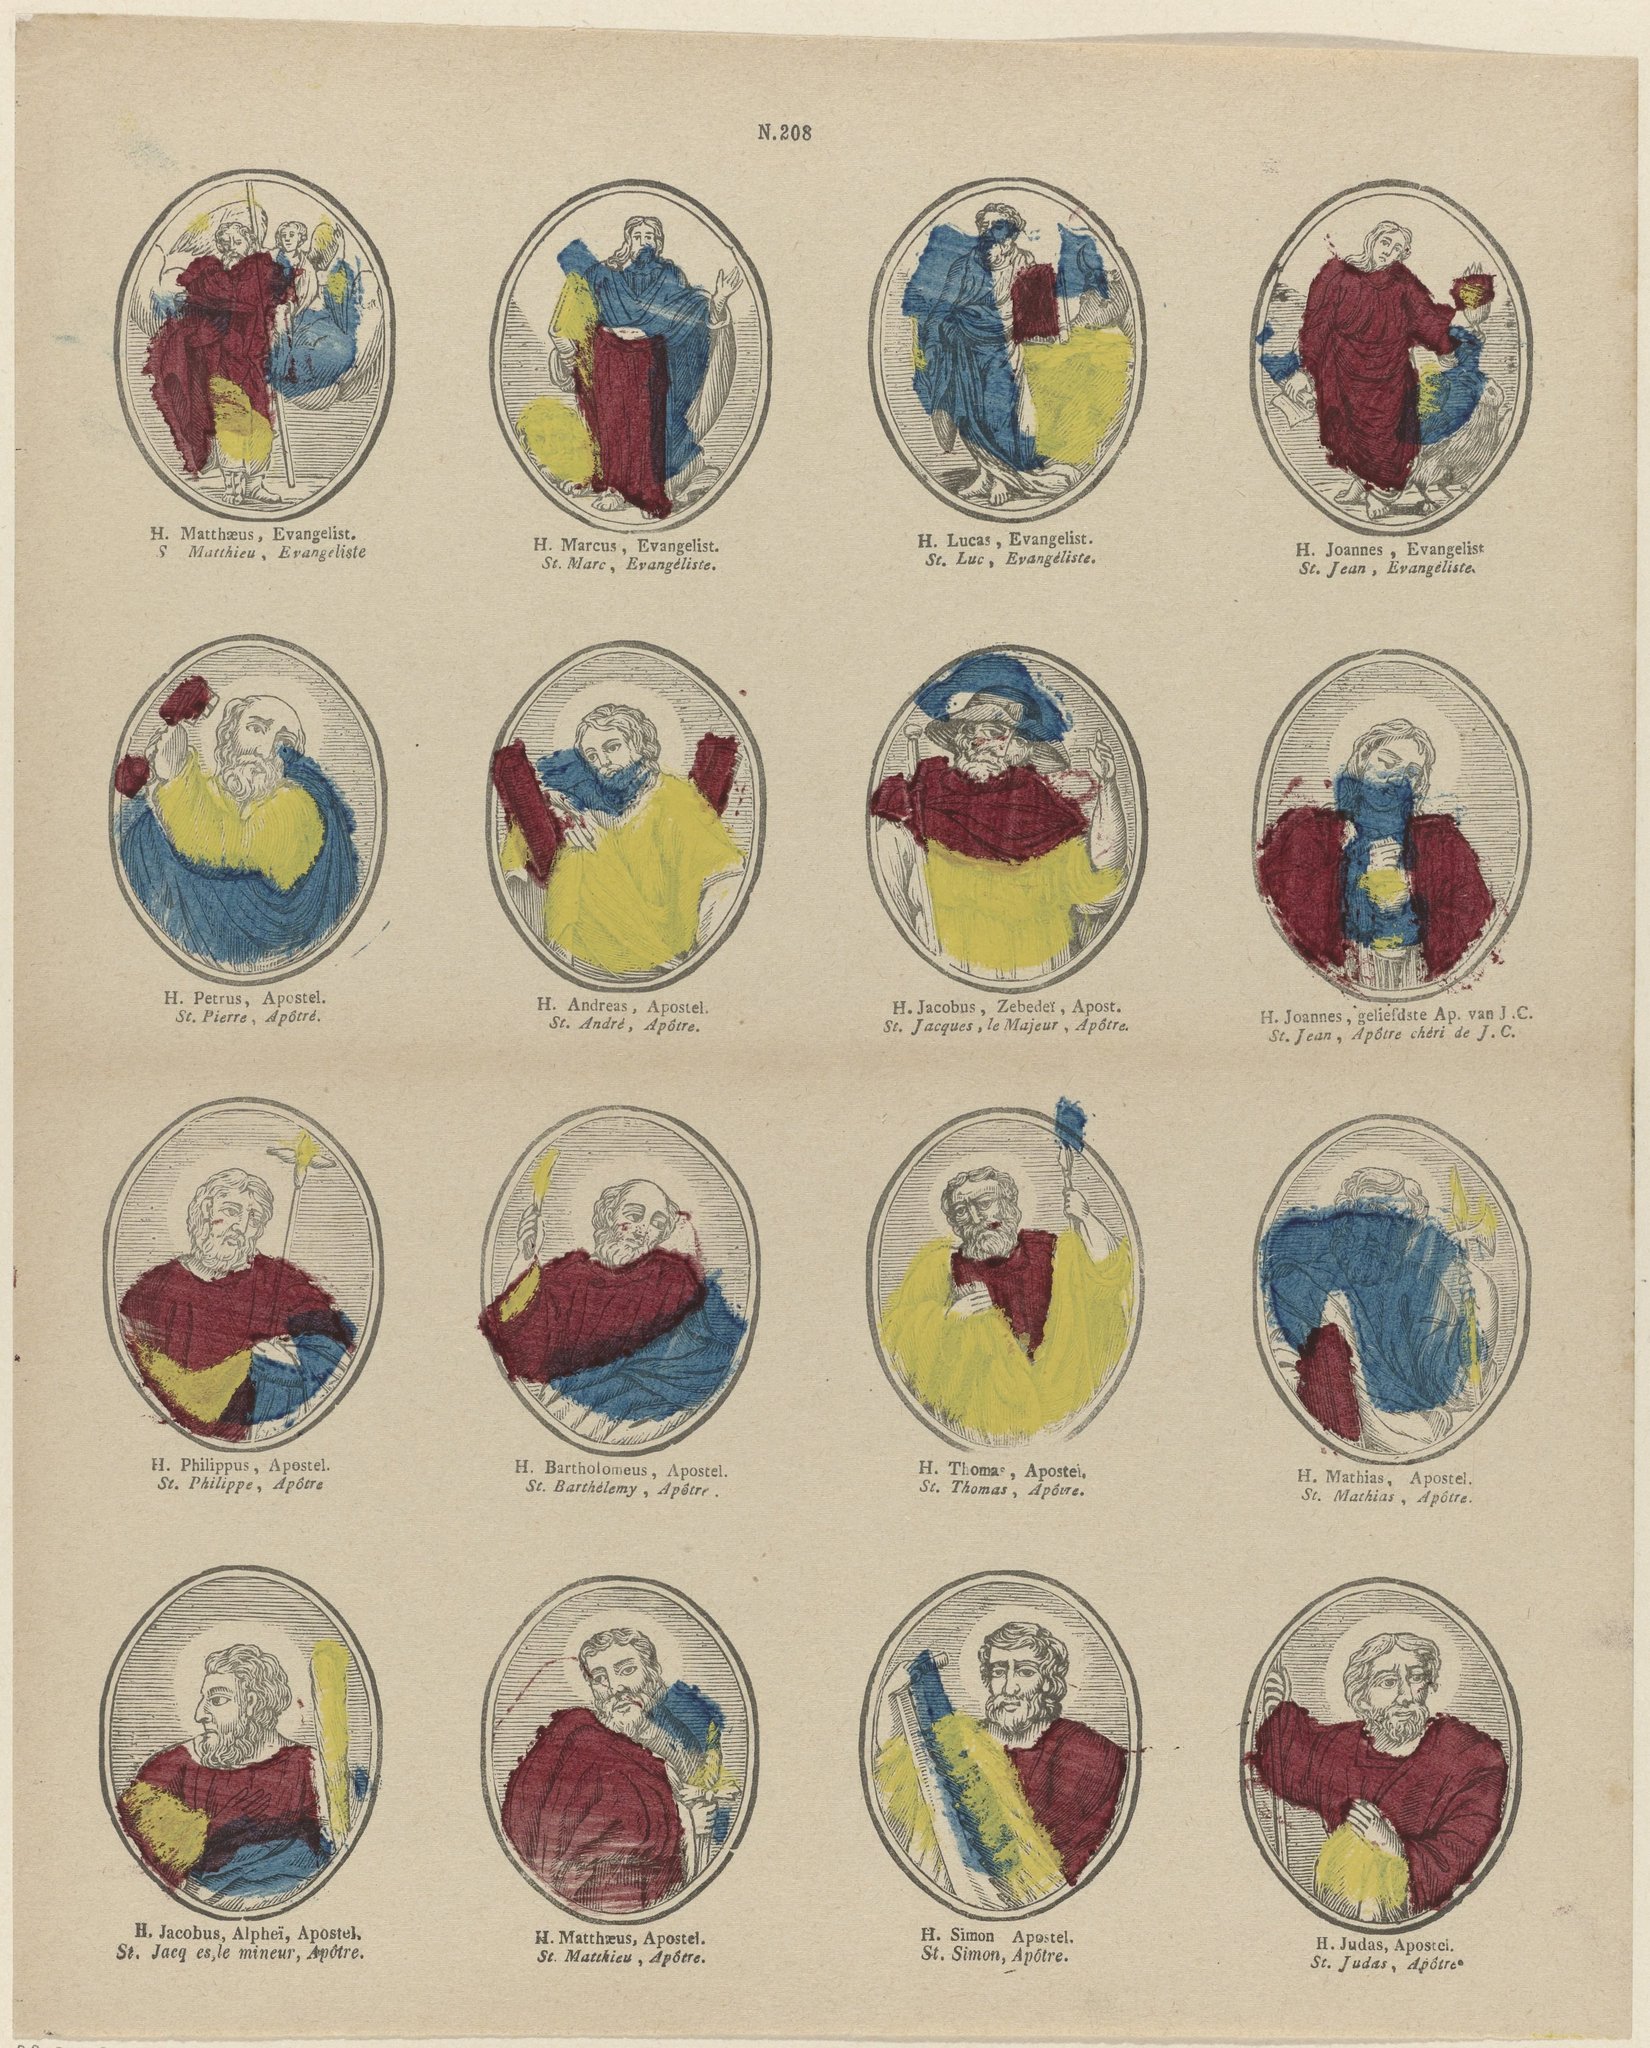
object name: popular print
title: Evangelisten en apostelen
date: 1800-1833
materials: paper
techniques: colour, letterpress printing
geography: turnhout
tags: evangelists, usually with books or scrolls (not in biblical context), saints, the twelve apostles (as a group), usually with books or scrolls (not in biblical context)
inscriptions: collector's mark: Lugt 2760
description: Blad met 16 medaillions met voorstellingen van de vier evangelisten en de apostelen. Onder elke voorstelling een onderschrift. Genummerd midden boven: N. 208.